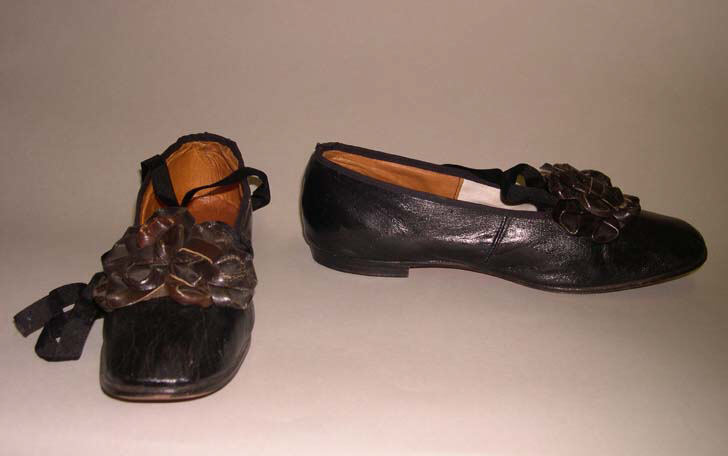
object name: slipper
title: Slippers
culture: american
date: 1850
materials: leather